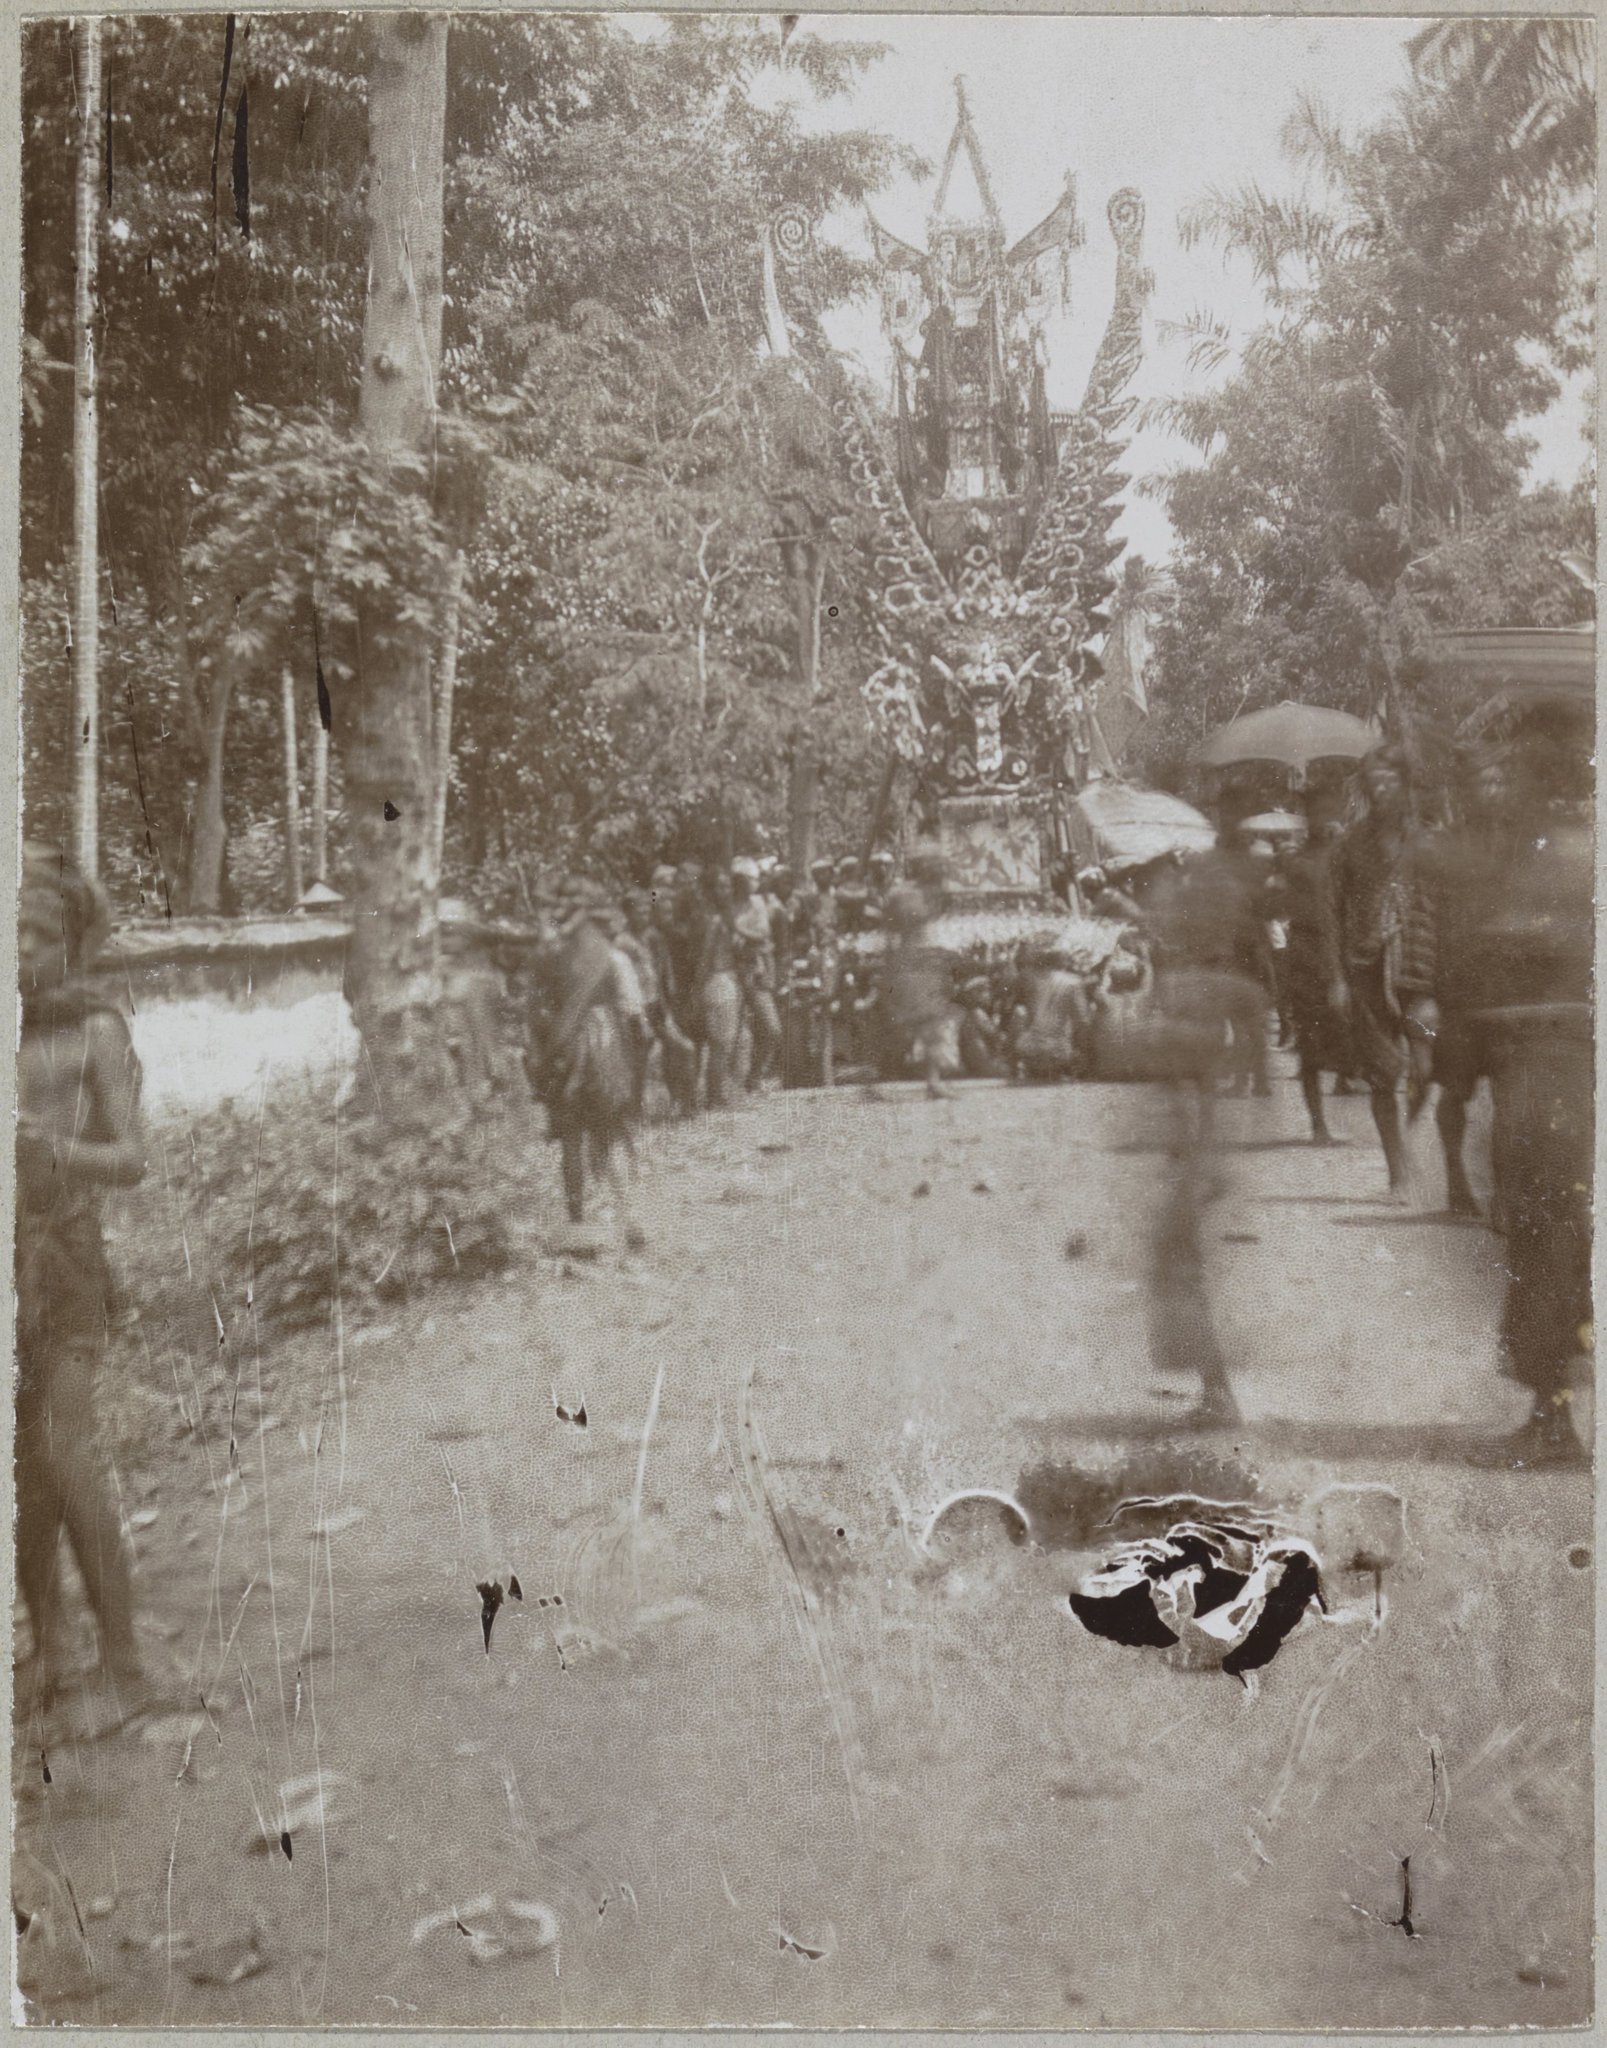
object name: photograph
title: Lijkbaar omringd door mensen, Bali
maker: Anonymous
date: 1910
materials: cardboard, paper, photographic support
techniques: collodion silver print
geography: bali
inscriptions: annotation: ‘Lijkverbrandingsfeesten te Bali 1910.’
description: Foto genomen tijdens lijkverbrandingsfeesten op Bali in 1910.